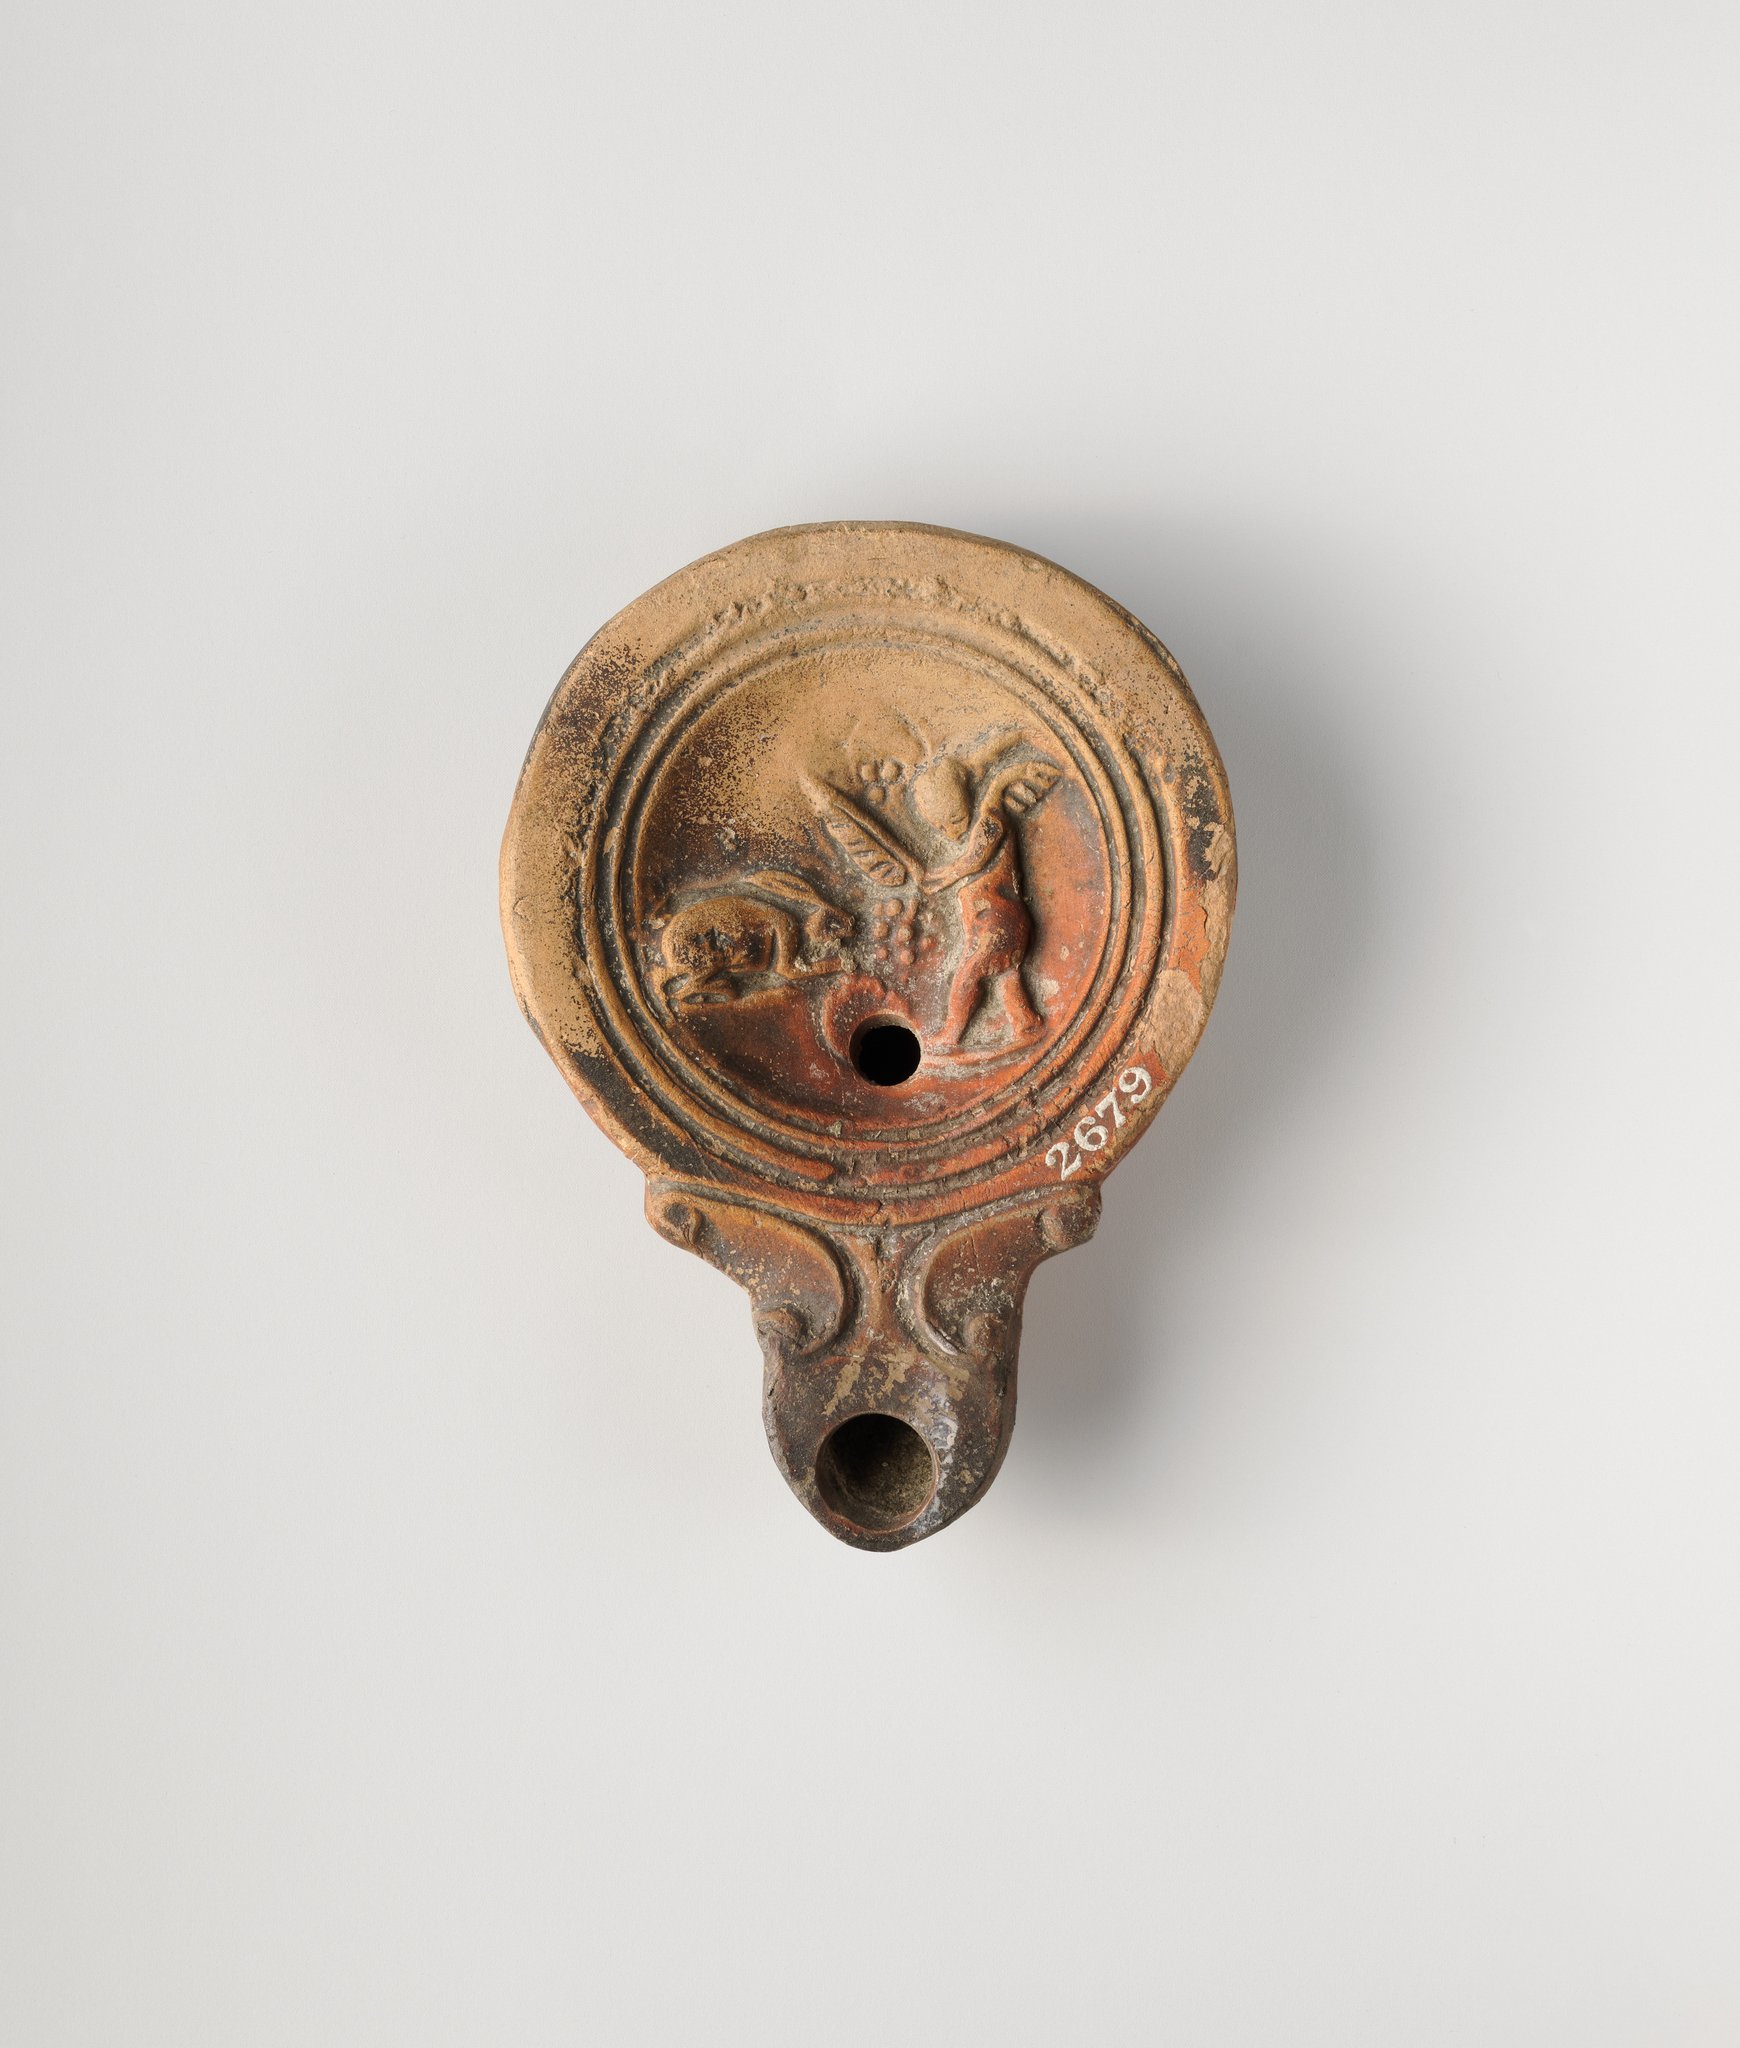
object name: lamp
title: Terracotta oil lamp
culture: roman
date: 40-100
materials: terracotta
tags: eros,rabbits